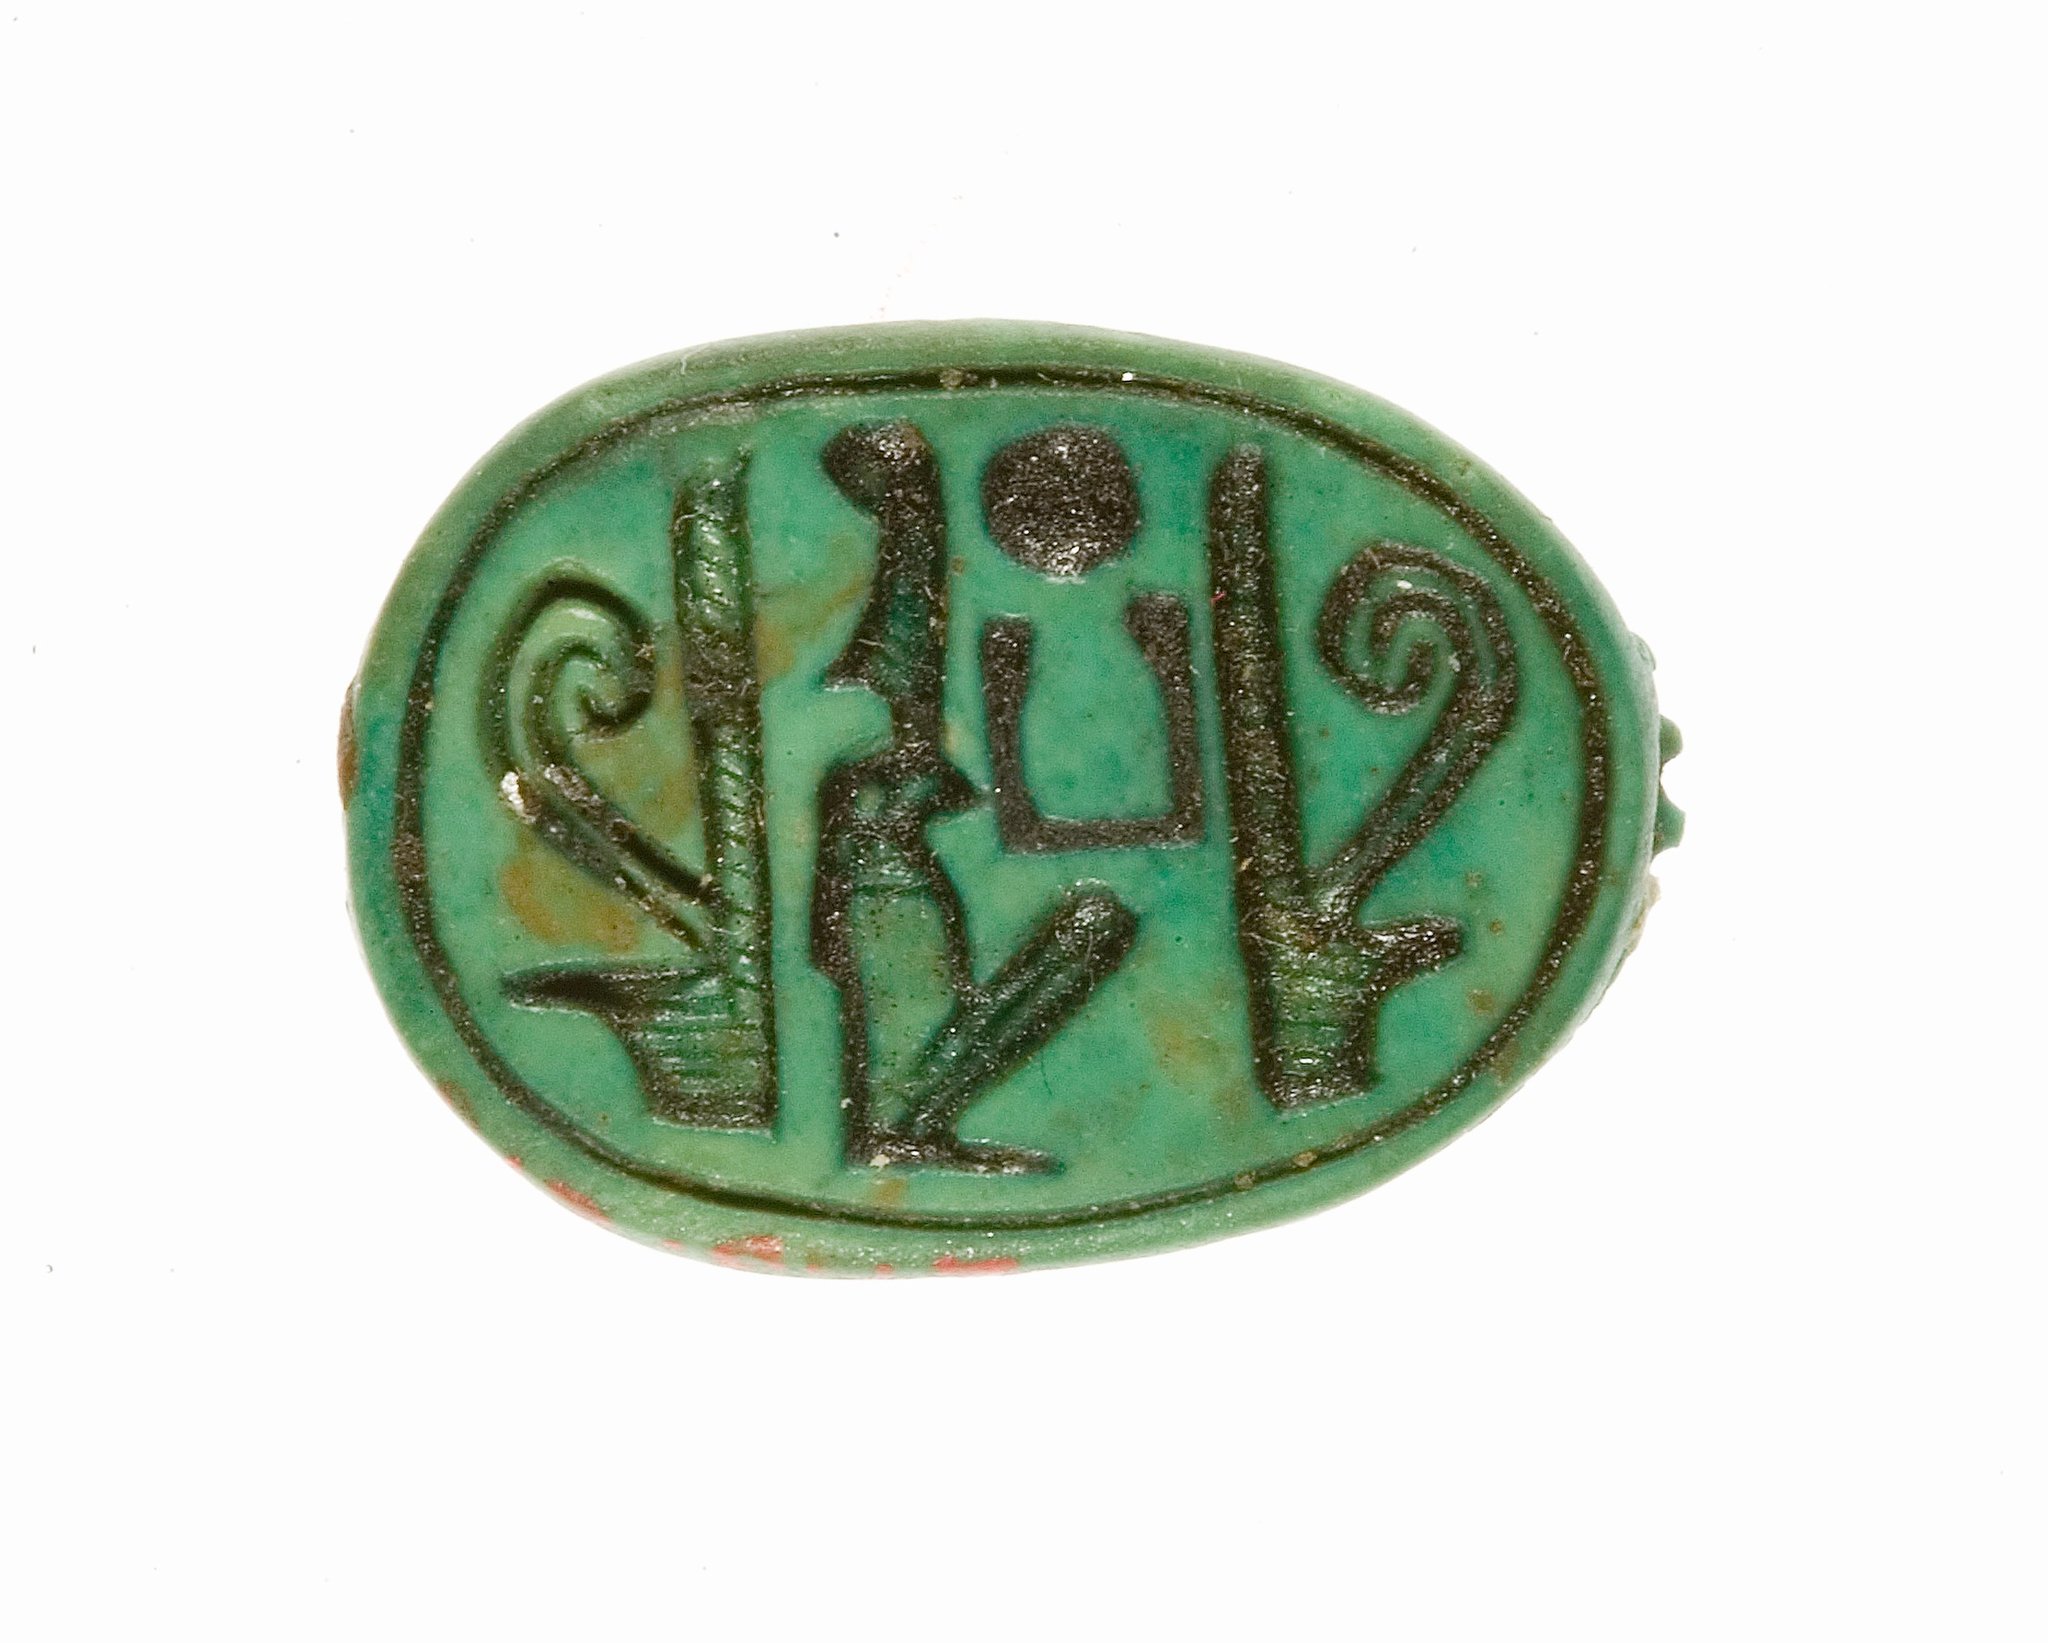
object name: scarab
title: Scarab Inscribed with the Name Maatkare (Hatshepsut) Flanked by Two Red Crowns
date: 1479-1458 BCE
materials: stone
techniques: glazing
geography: egypt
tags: hieroglyphs,scarabs